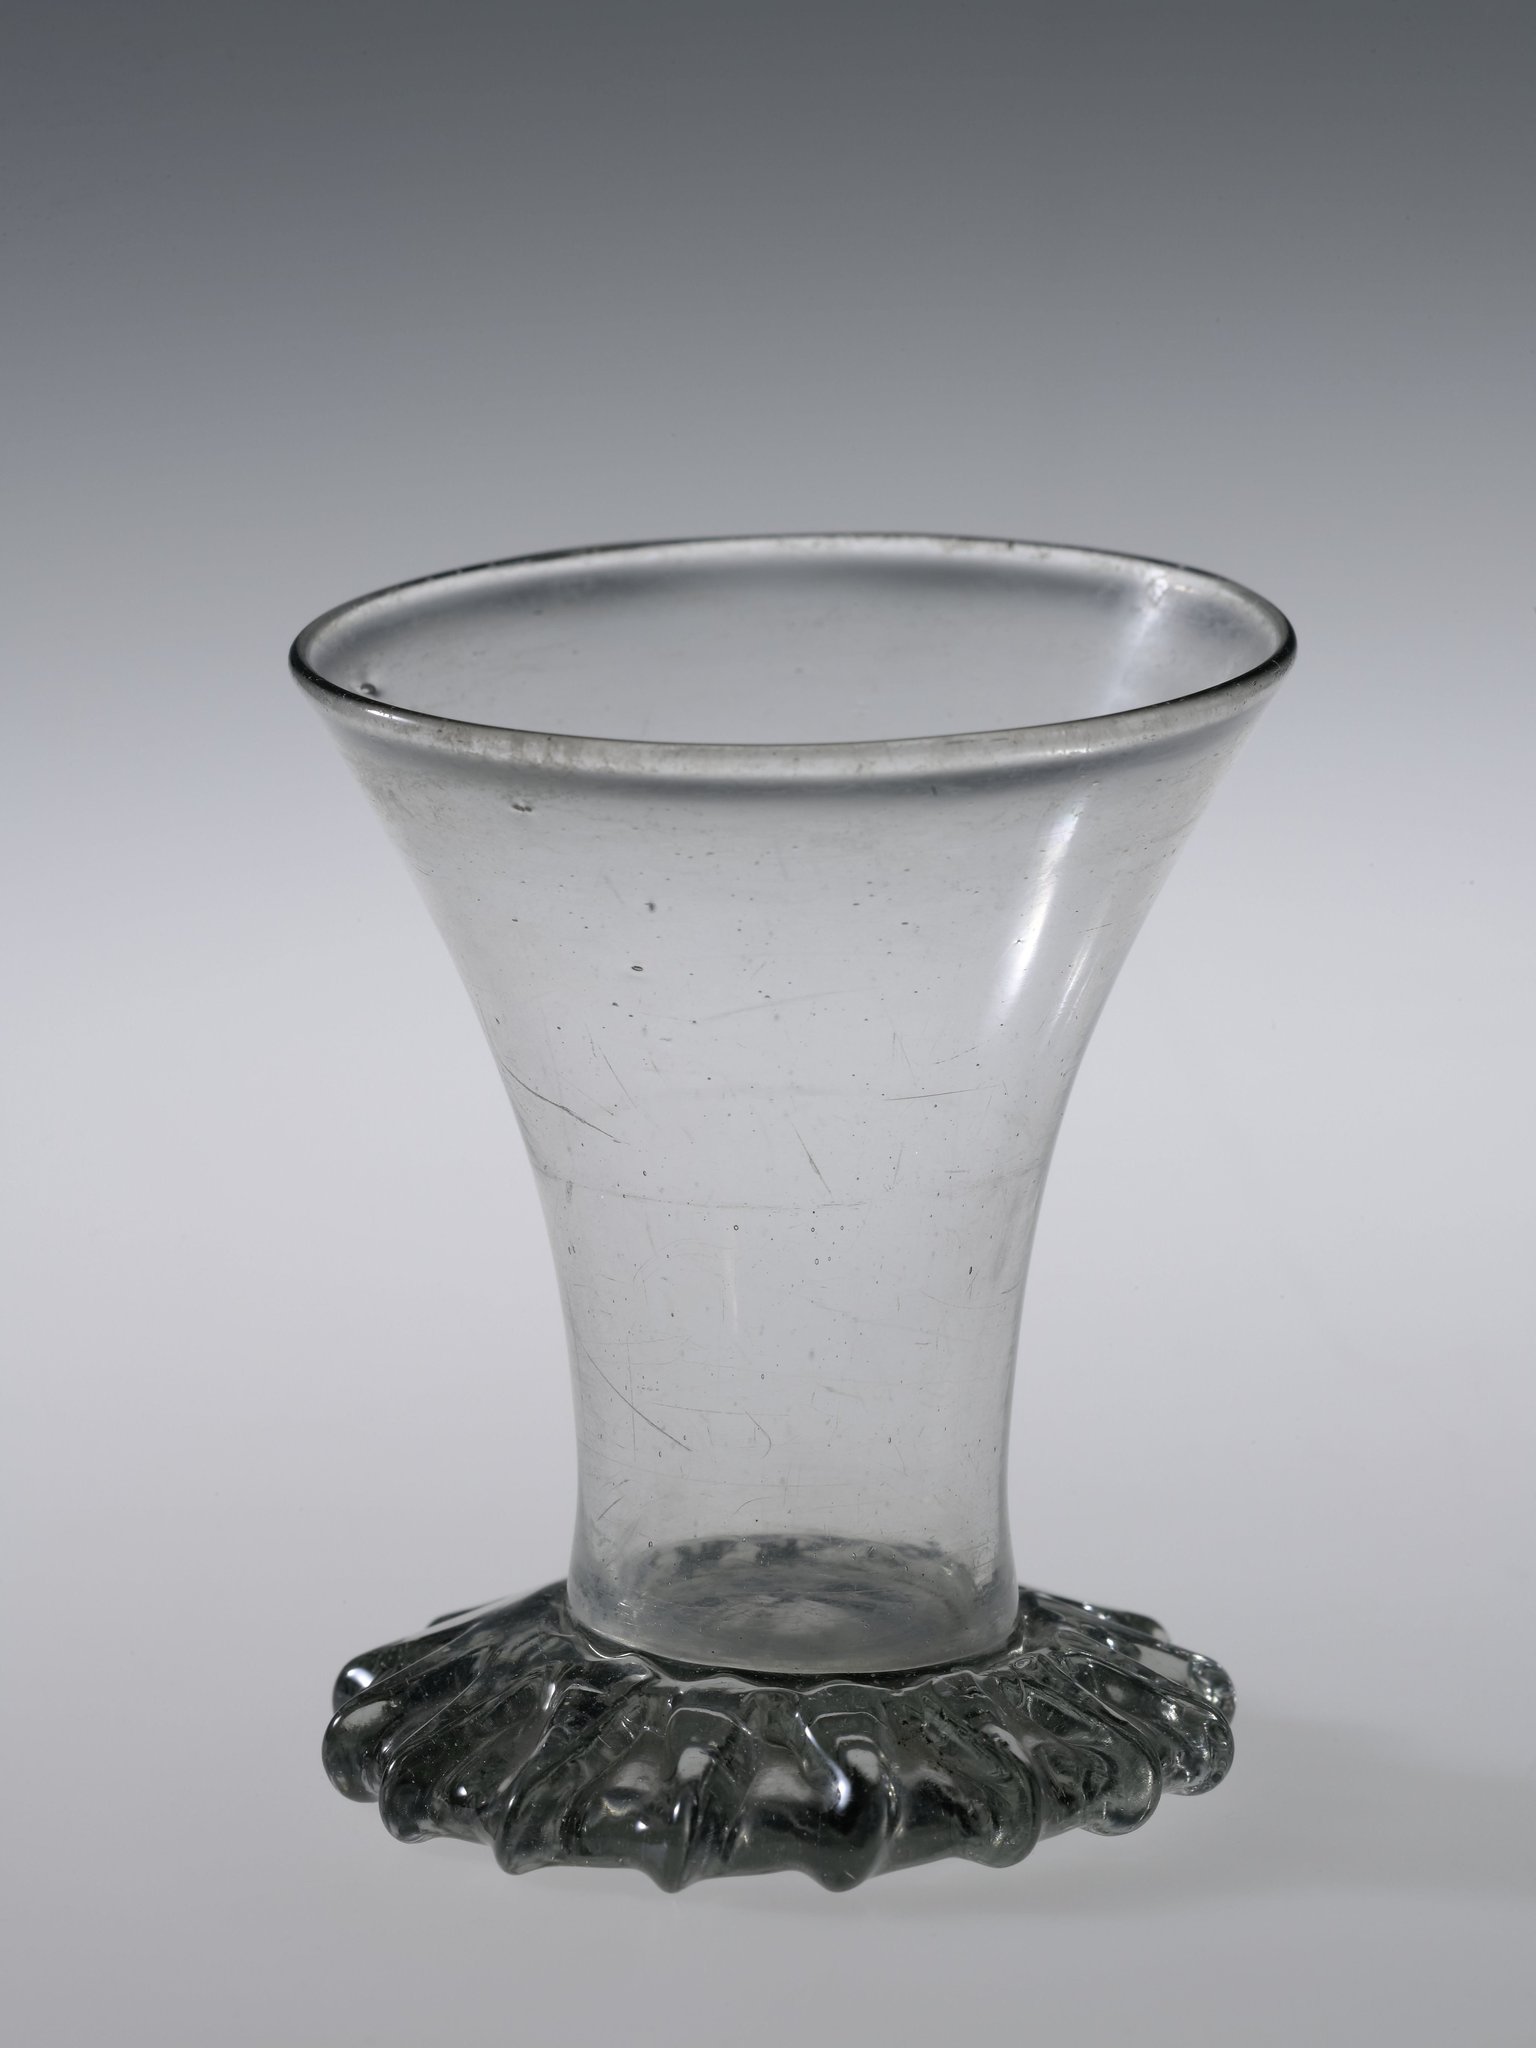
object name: cup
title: Beker met gelobde voet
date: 1700-1800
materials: glass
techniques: glassblowing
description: Kleine beker met gelobde voet en trompetvormige kelk.